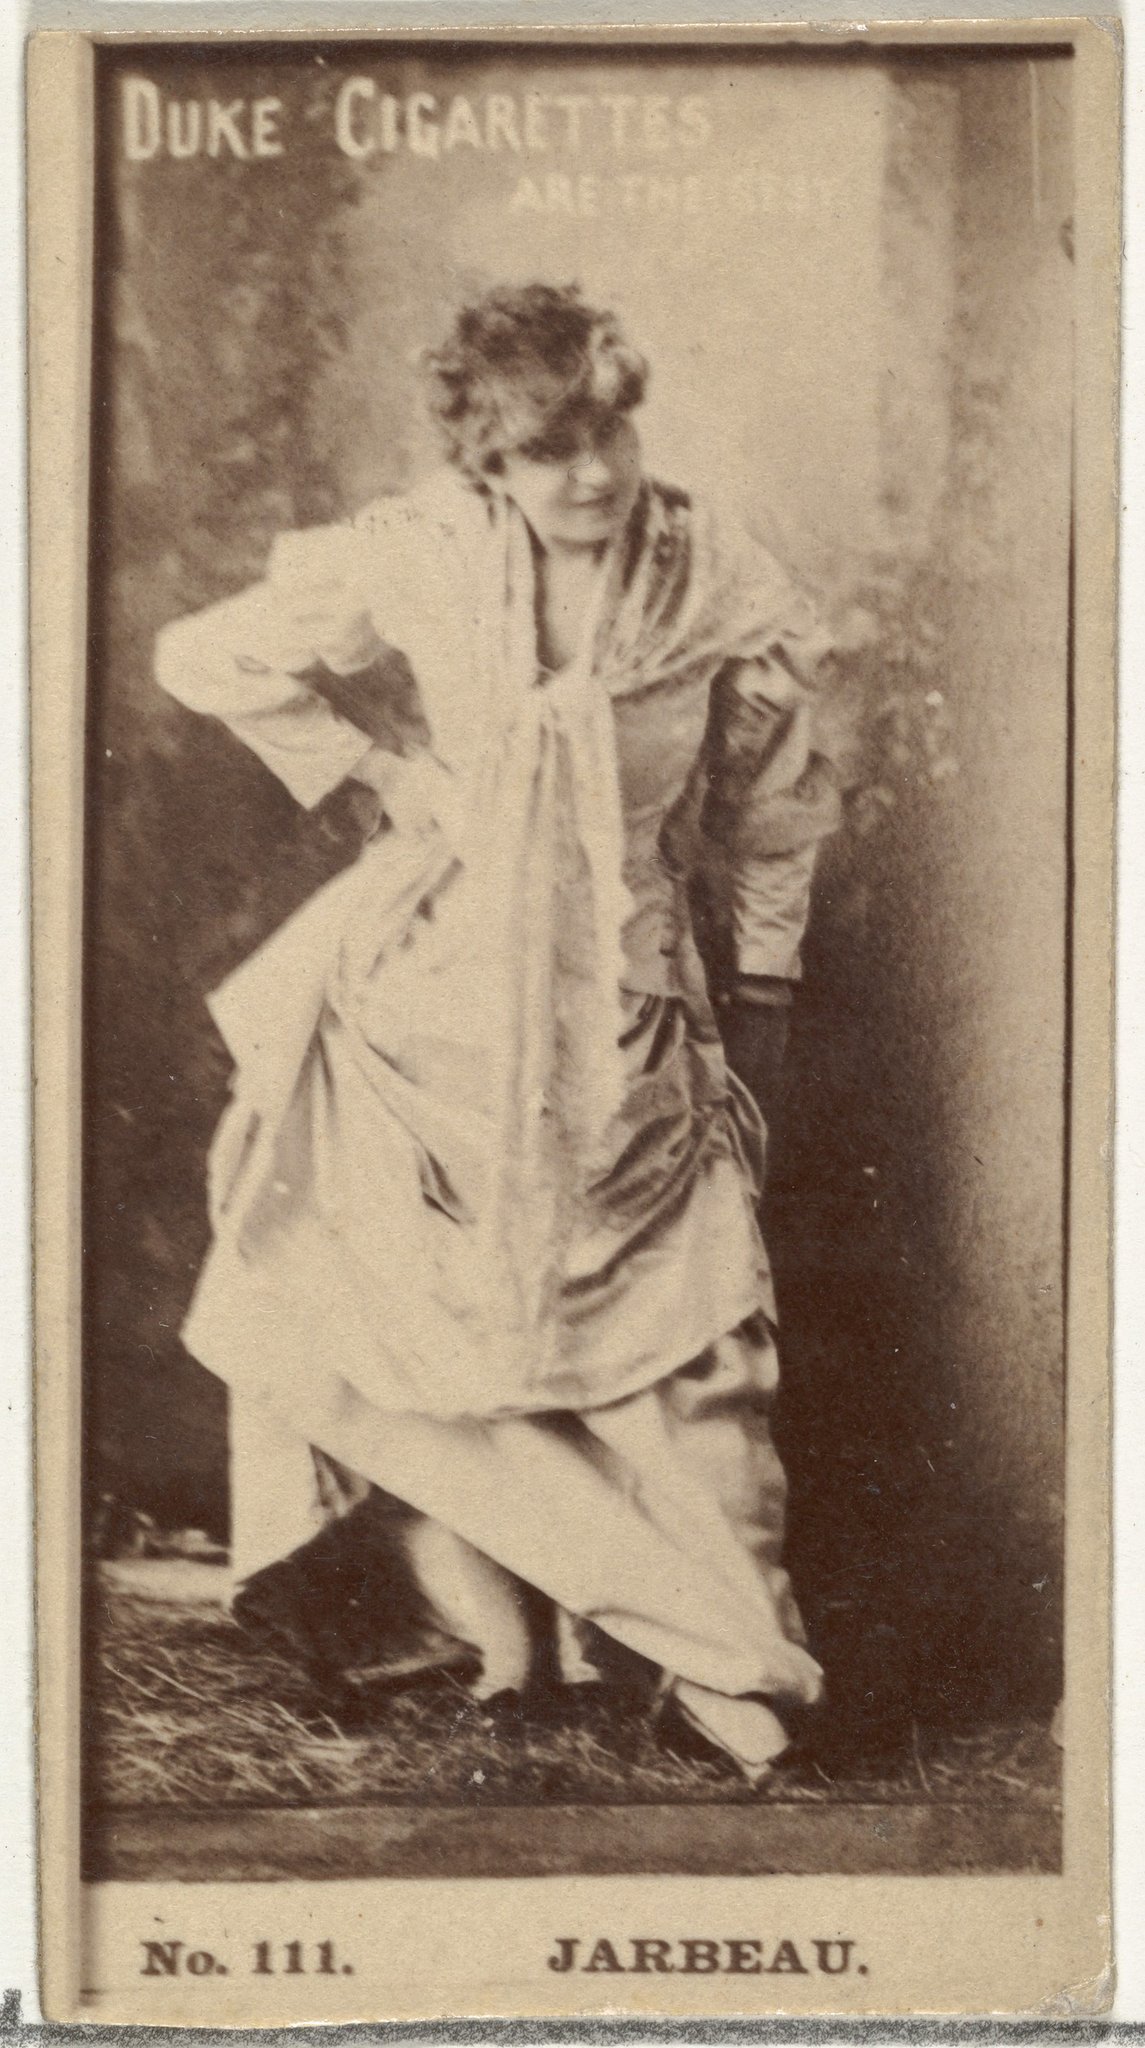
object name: photograph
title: Card Number 111, Miss Jarbeau, from the Actors and Actresses series (N145-6) issued by Duke Sons & Co. to promote Duke Cigarettes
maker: w. duke, sons & co.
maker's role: publisher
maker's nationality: american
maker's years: 1870-1920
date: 1880-1889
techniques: albumen silver print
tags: portraits,women,actresses